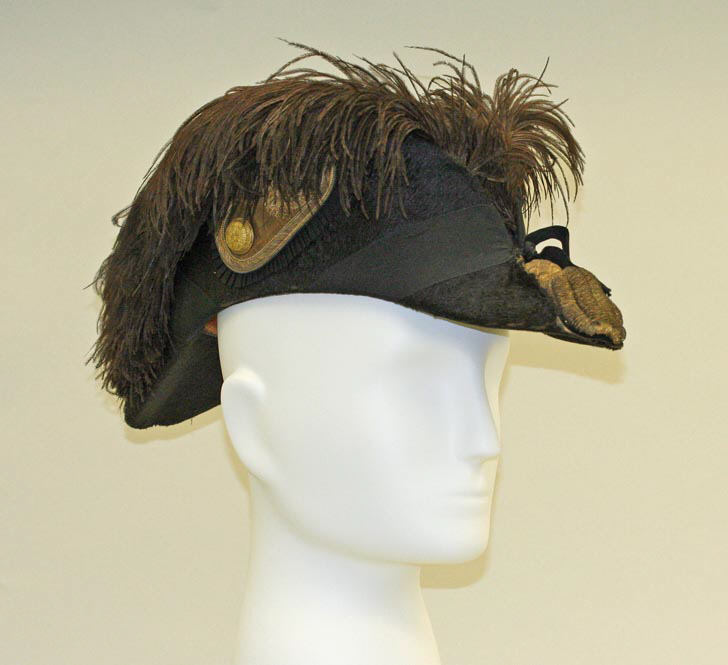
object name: hat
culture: american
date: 1801-1900